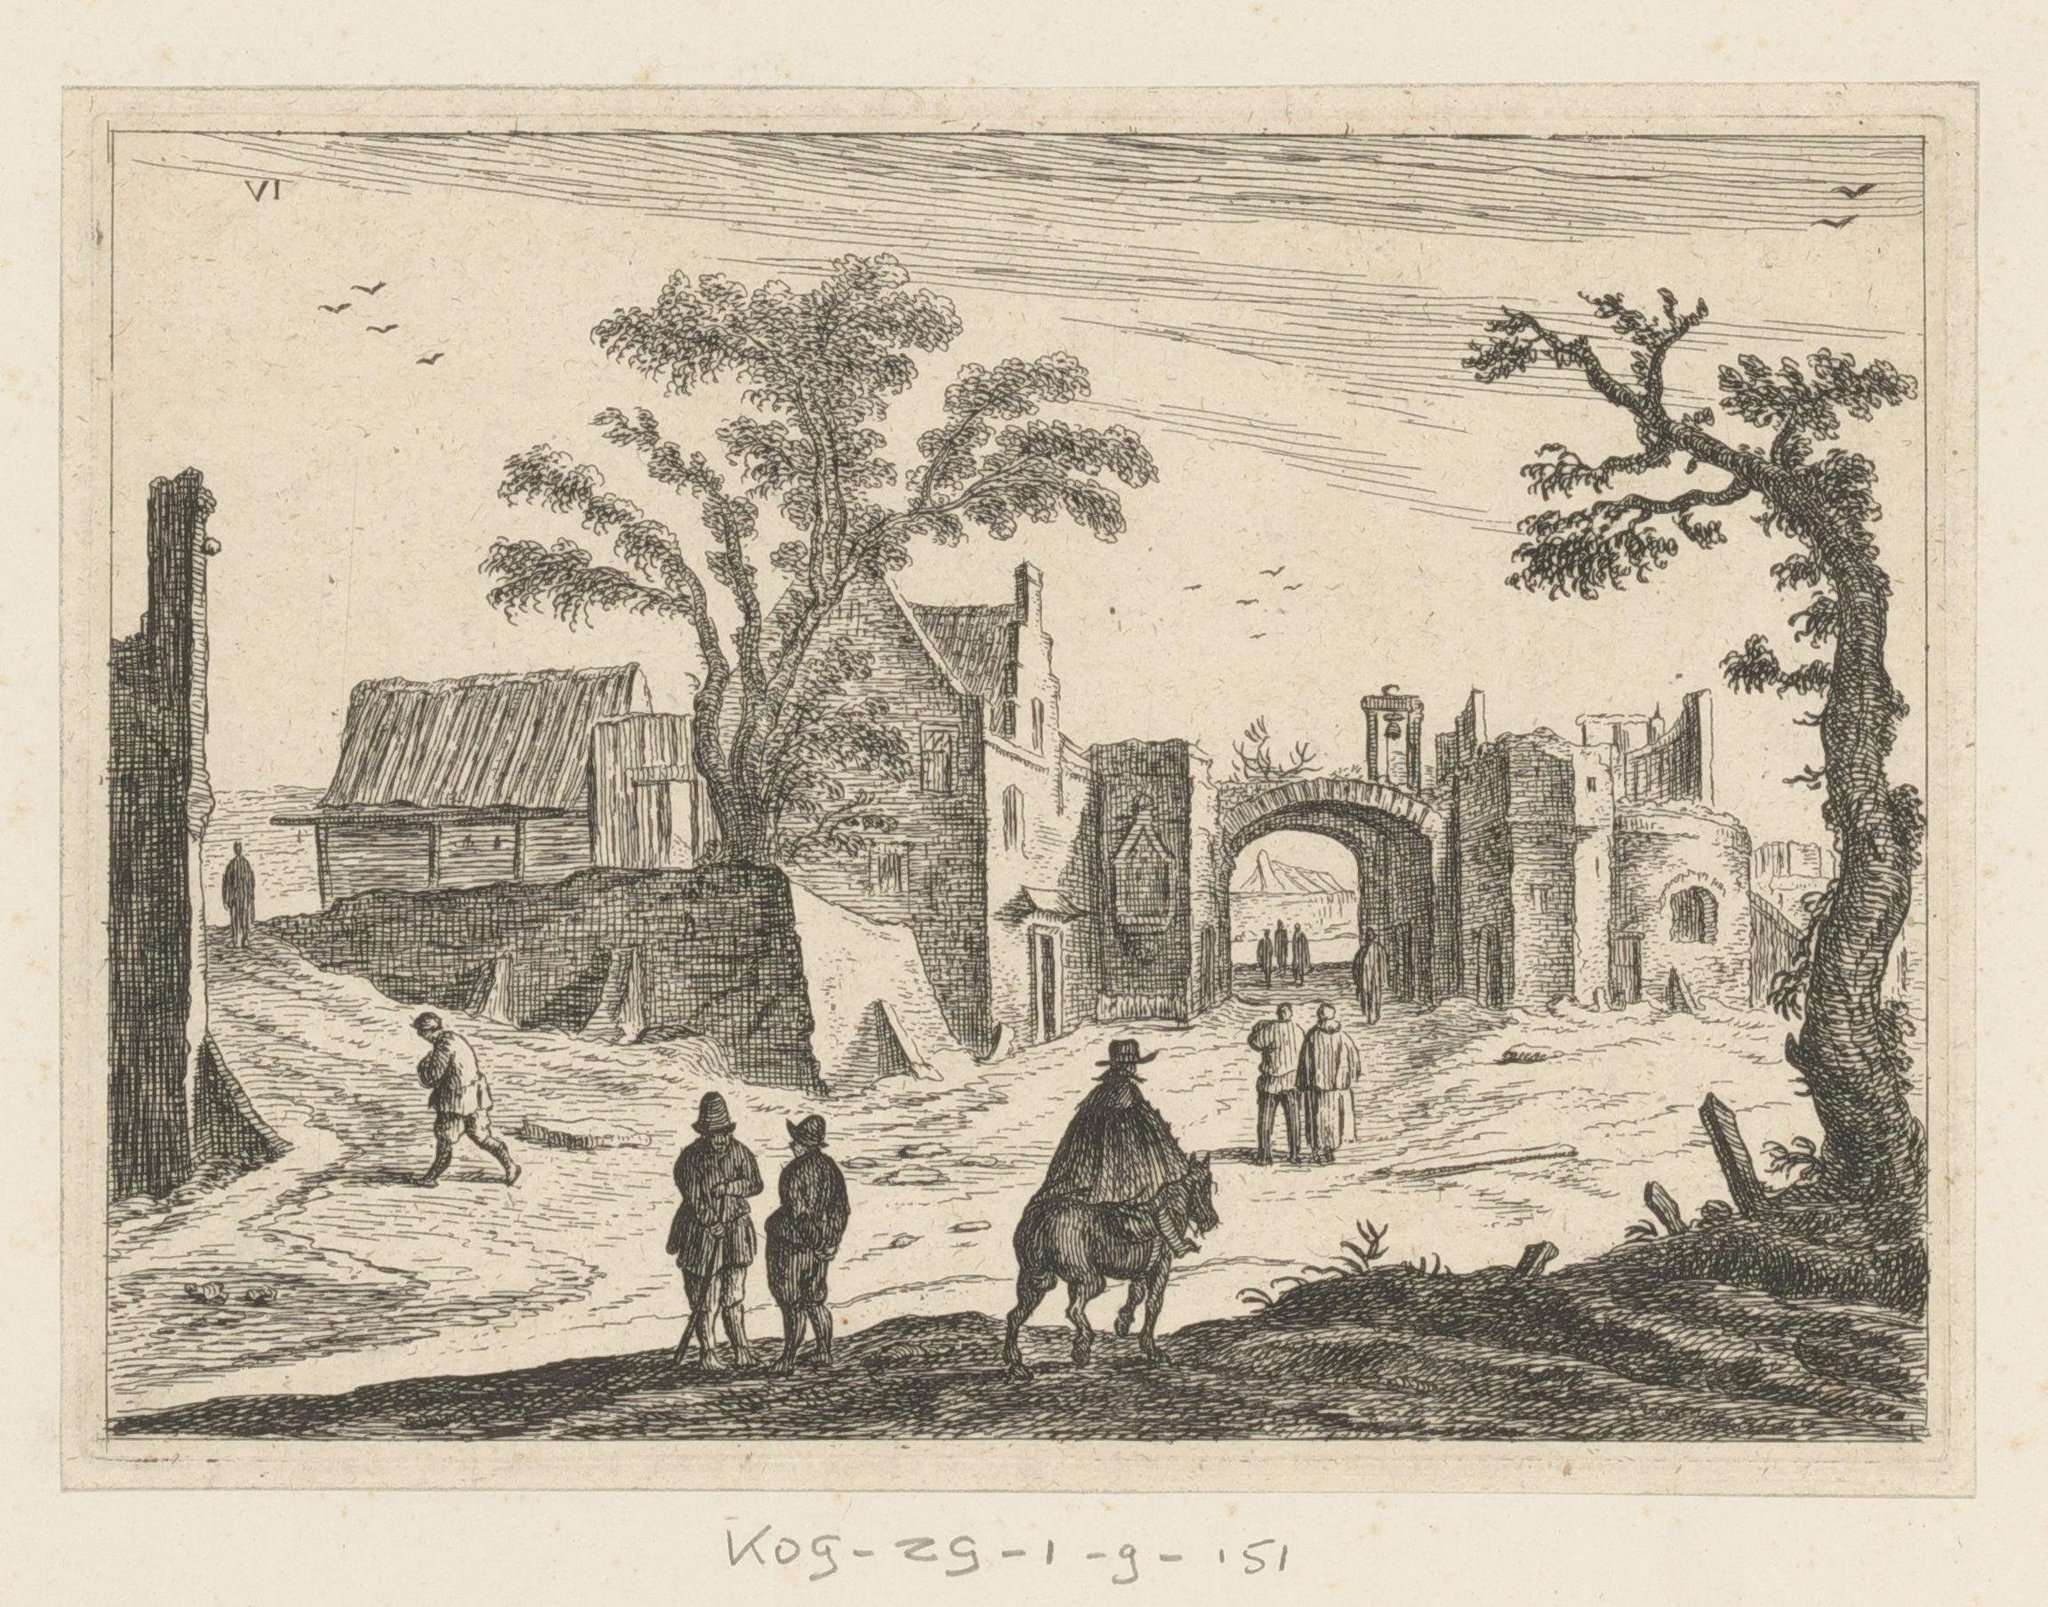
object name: print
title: Landschappen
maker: johannes gronsveld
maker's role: draughtsman, painter, print maker, publisher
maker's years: 1658-1728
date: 1679-1728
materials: paper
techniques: etching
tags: riding a horse, ass, or mule; rider, horseman, city-gate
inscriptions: collector's mark: Lugt 1641, stamp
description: Landschap met stadspoort en een man te paard en links van hem twee mannen in gesprek. Zesde prent uit een serie van acht met landschappen. Rechtsboven genummerd: VI. Onderwerpsrubrieken binnen de Atlas Zeden en Gewoonten: Handel, nijverheid en verkeer, Buitenleven.